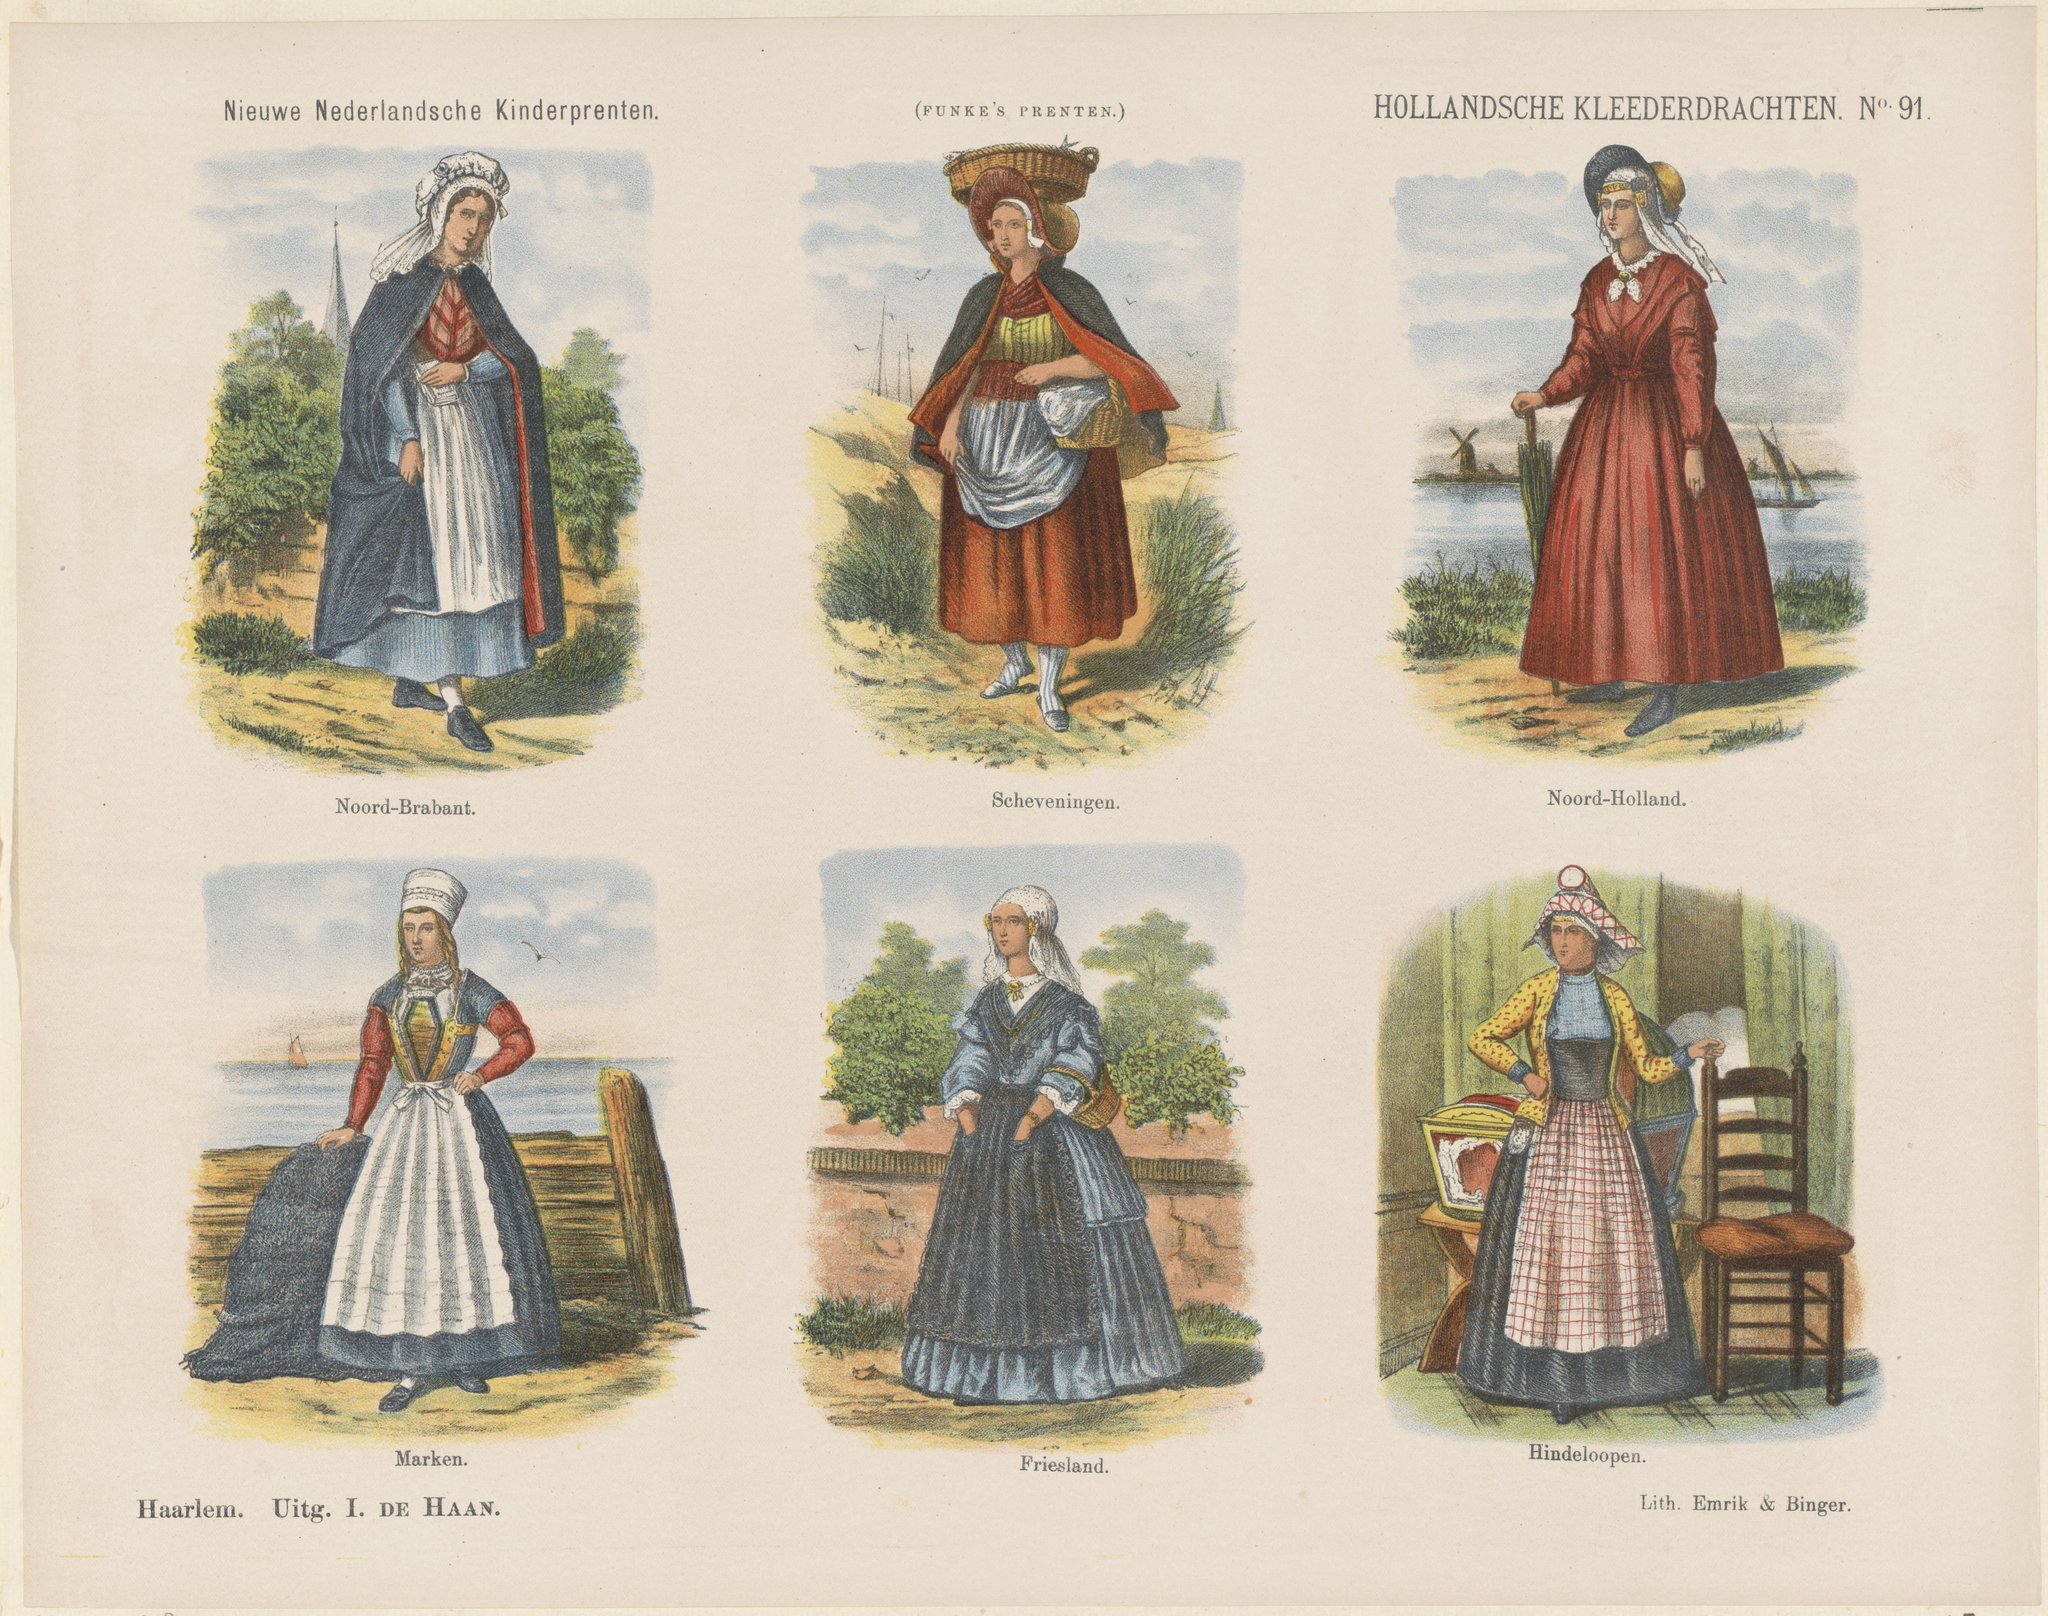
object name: popular print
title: Funke's prenten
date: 1875-1903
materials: paper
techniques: lithograph, letterpress printing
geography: haarlem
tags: historical costume, folk costume, regional costume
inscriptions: collector's mark: Lugt 2760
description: Blad met 6 voorstellingen van vrouwen in verschillende Nederlandse klederdrachten. Onder elke afbeelding een onderschrift. Genummerd rechtsboven: No. 91.